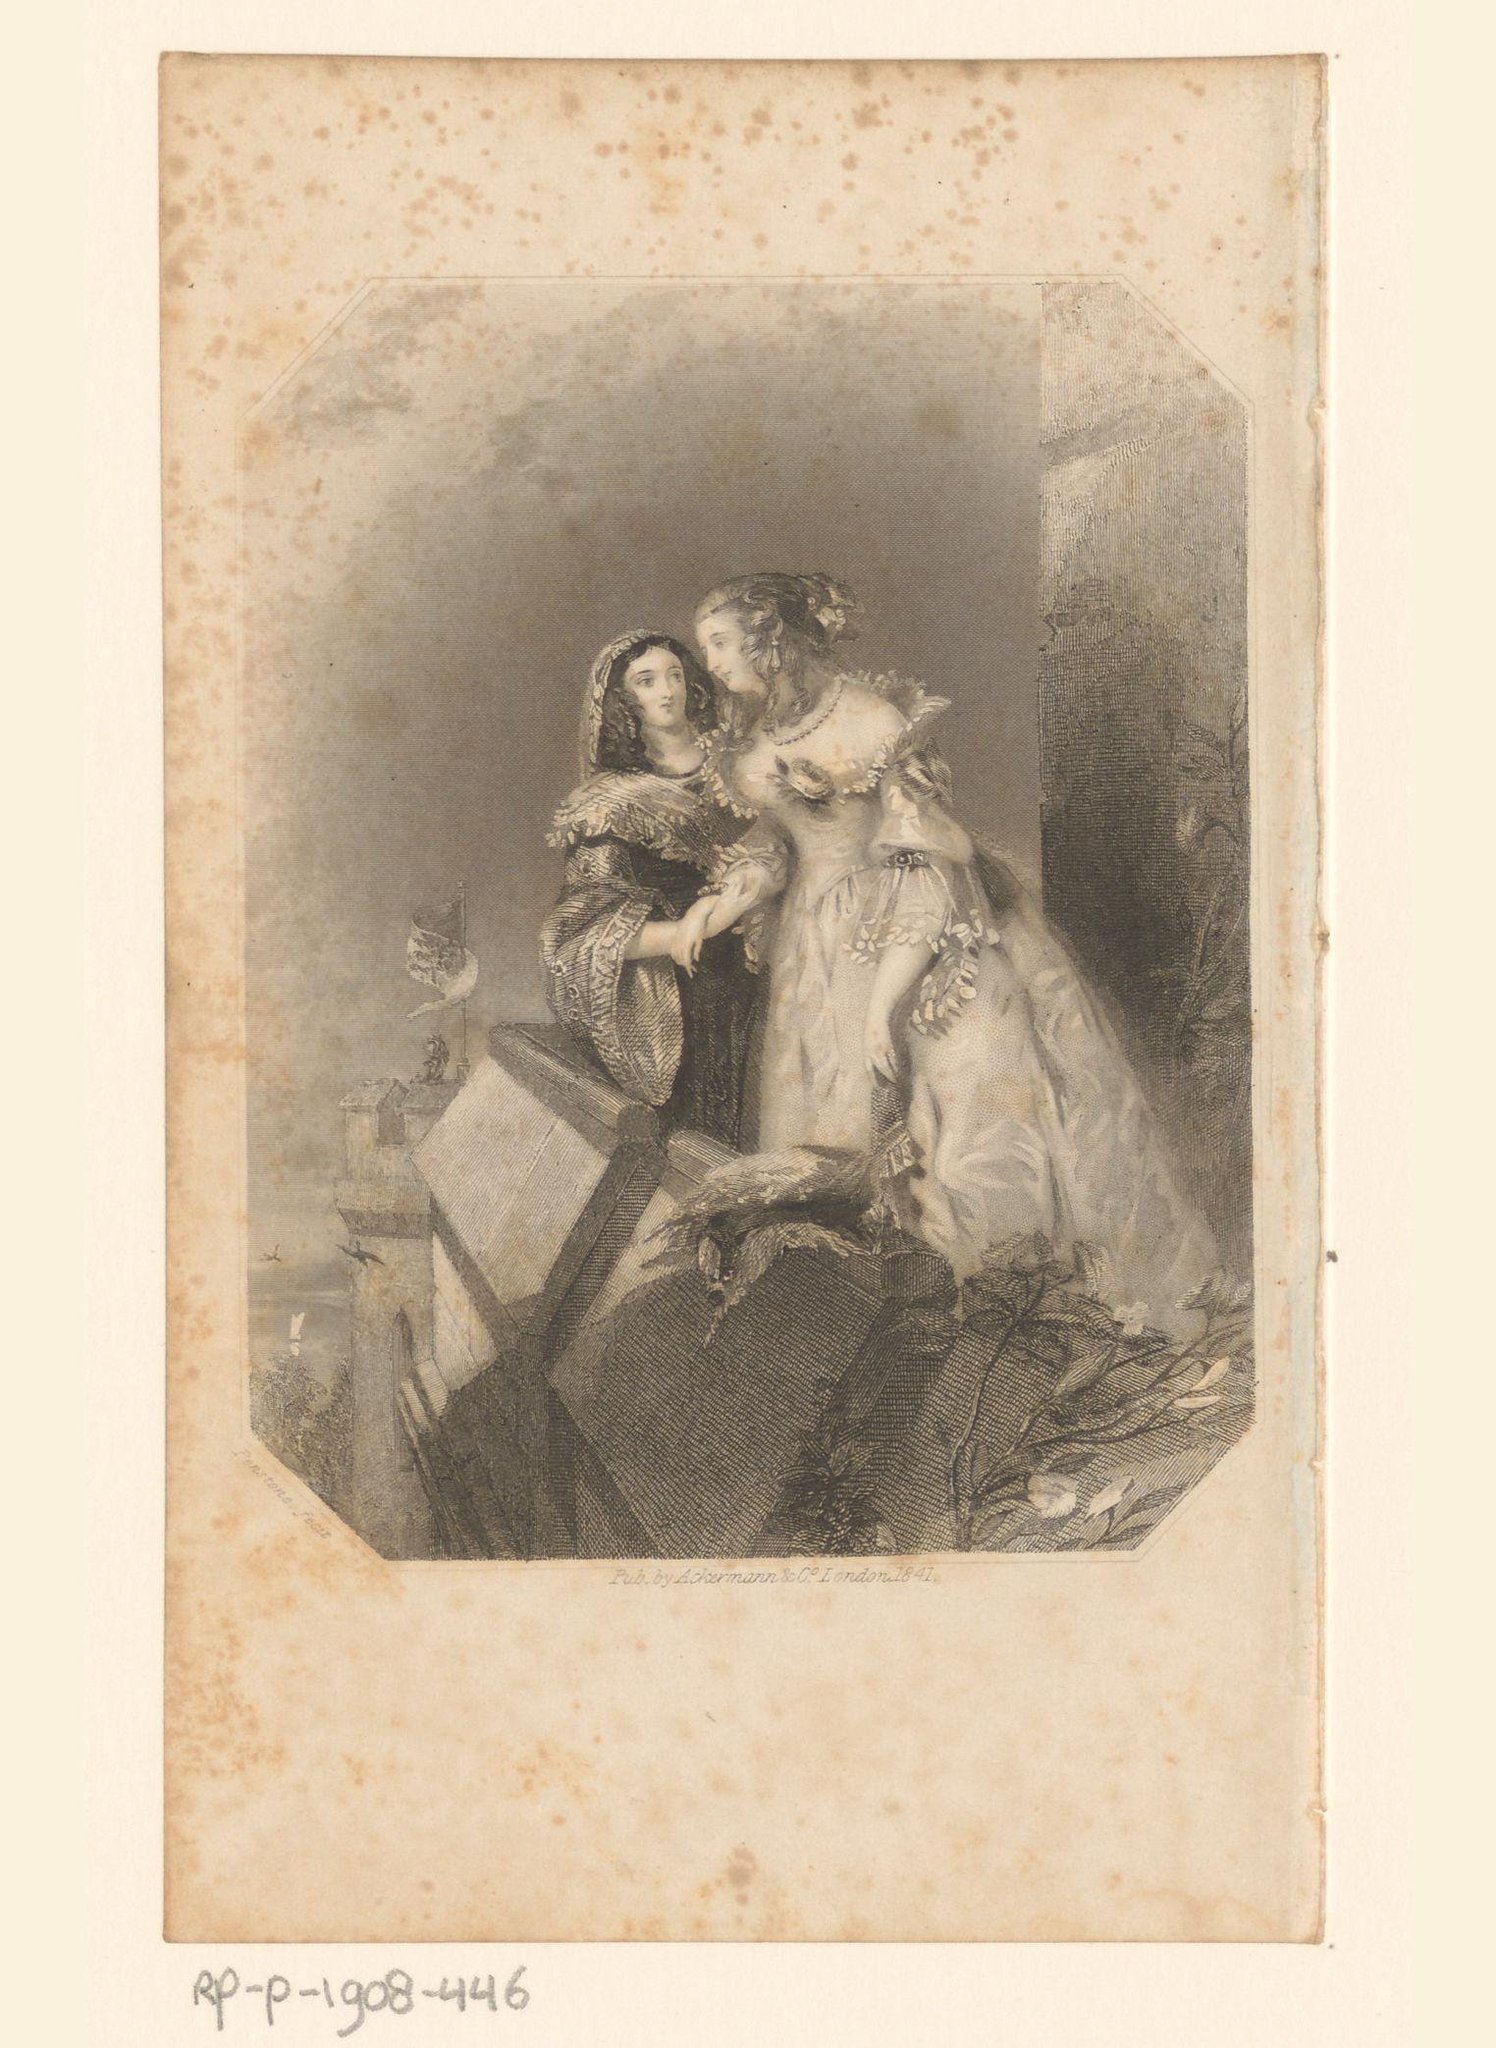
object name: print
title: Twee vrouwen op het balkon van een hoge toren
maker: john jewell penstone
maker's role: print maker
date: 1841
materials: paper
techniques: etching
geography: london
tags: tower (of house or building)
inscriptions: collector's mark: Lugt 2228